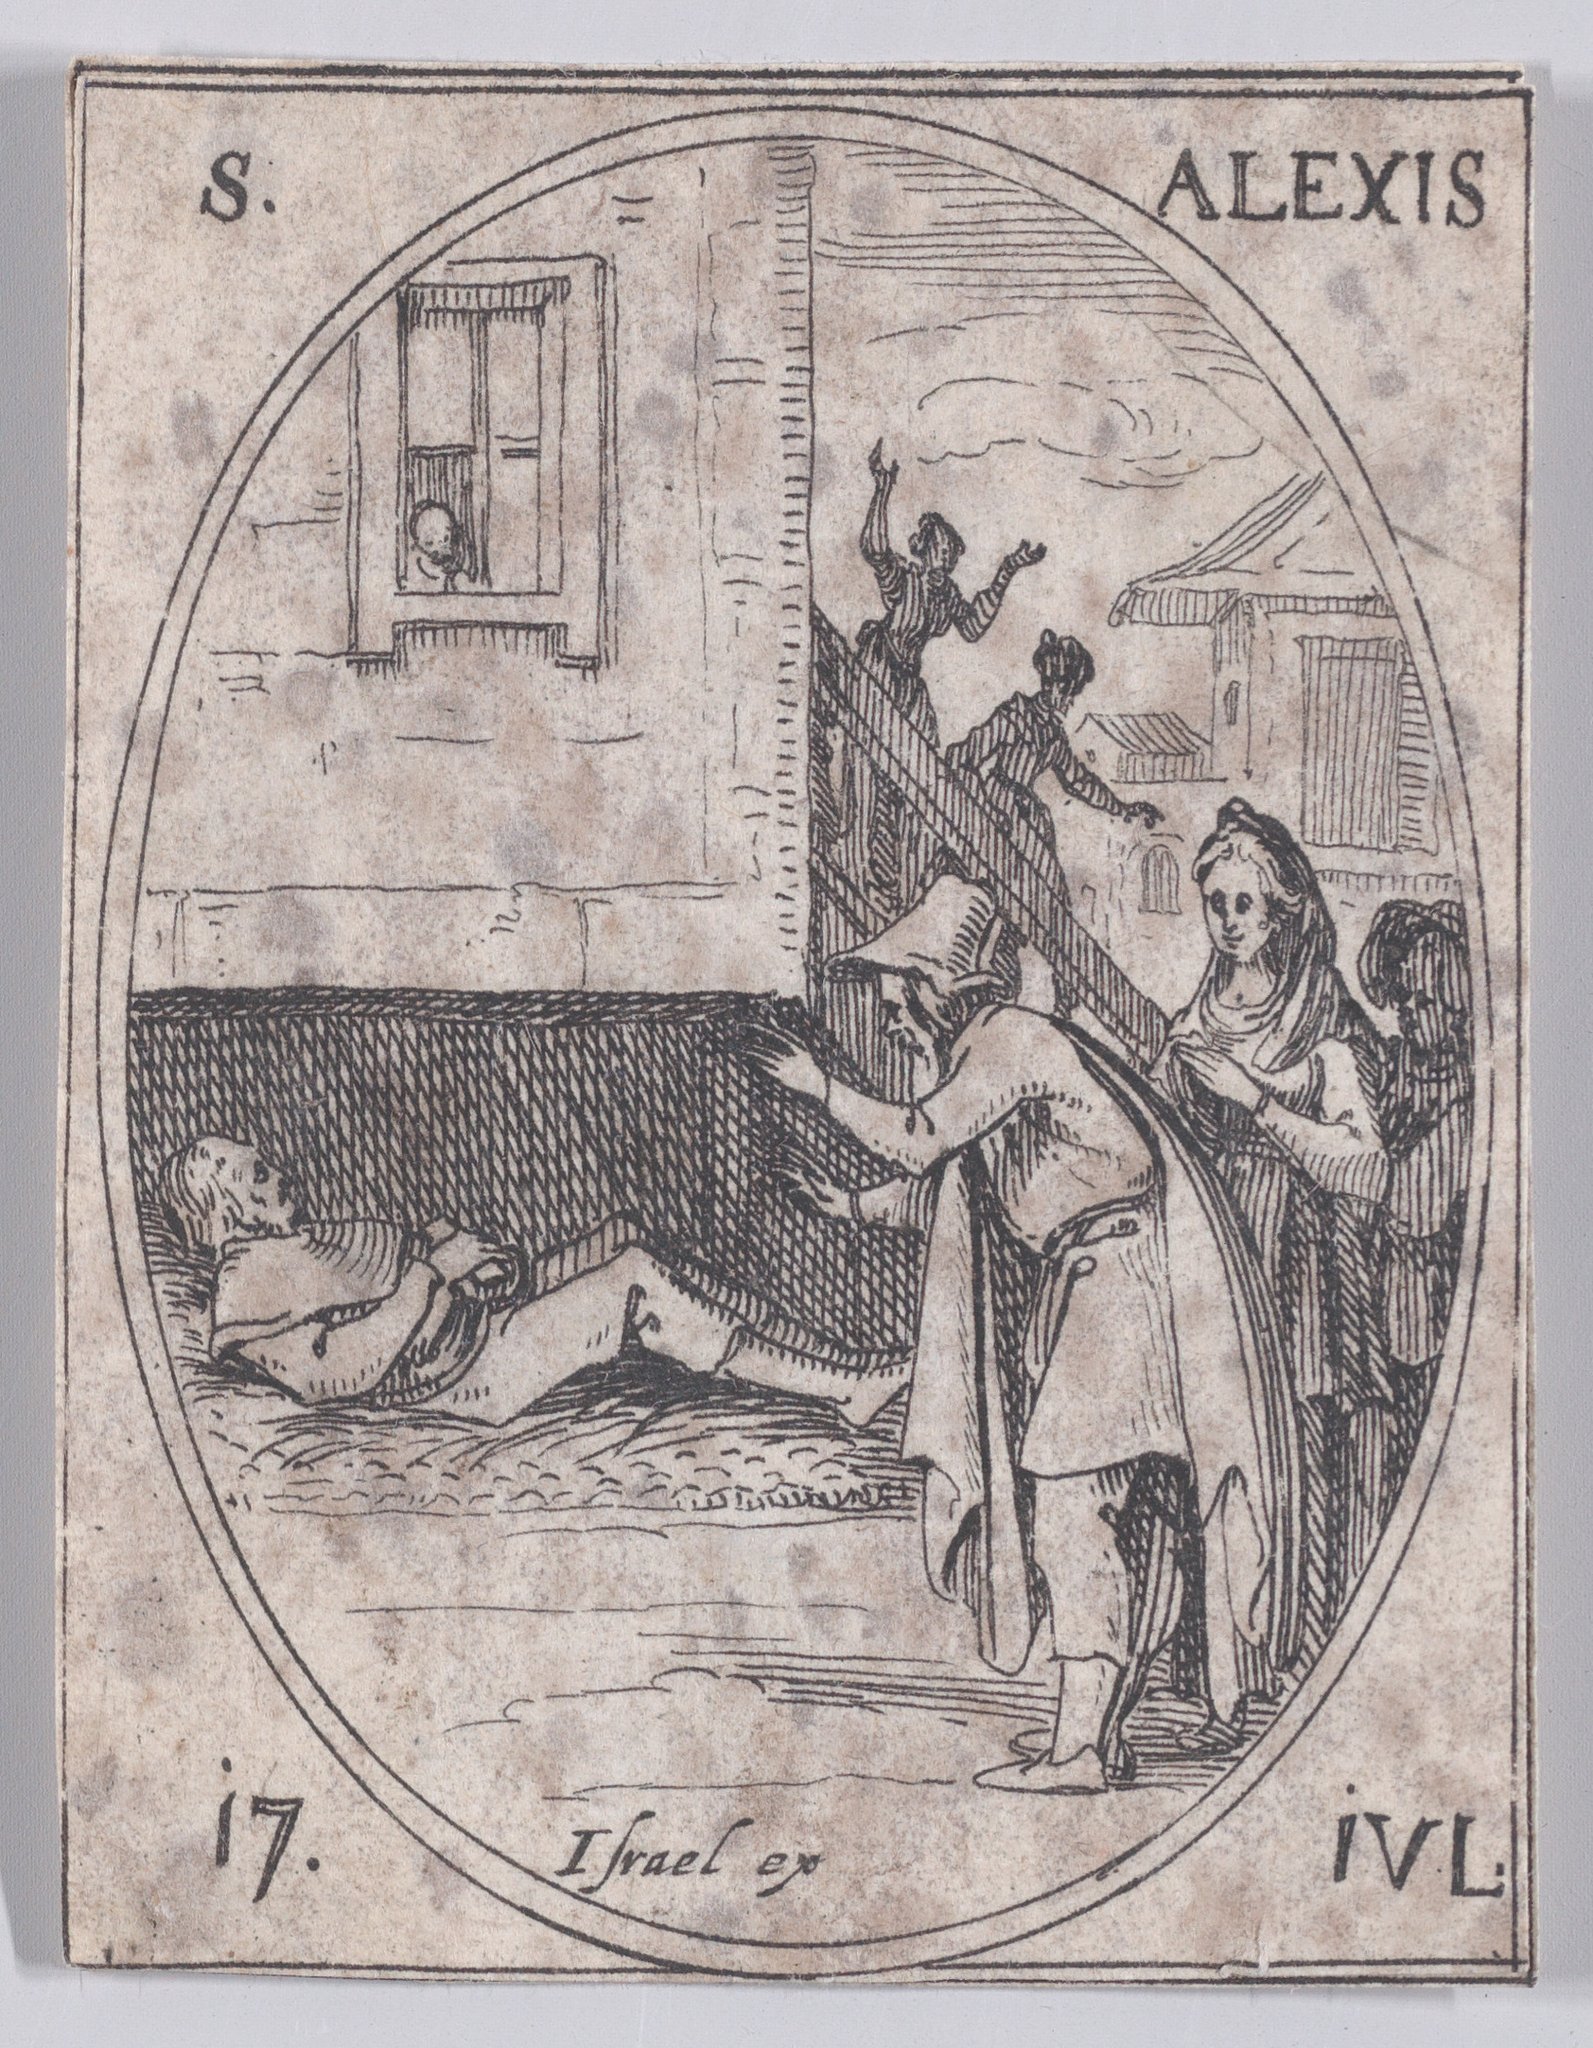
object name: print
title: St. Alexis, July 17th, from "Les Images De Tous Les Saincts et Saintes de L'Année" (Images of All of the Saints and Religious Events of the Year)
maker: jacques callot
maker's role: artist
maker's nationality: french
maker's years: 1592-1635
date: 1636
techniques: etching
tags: men,saints